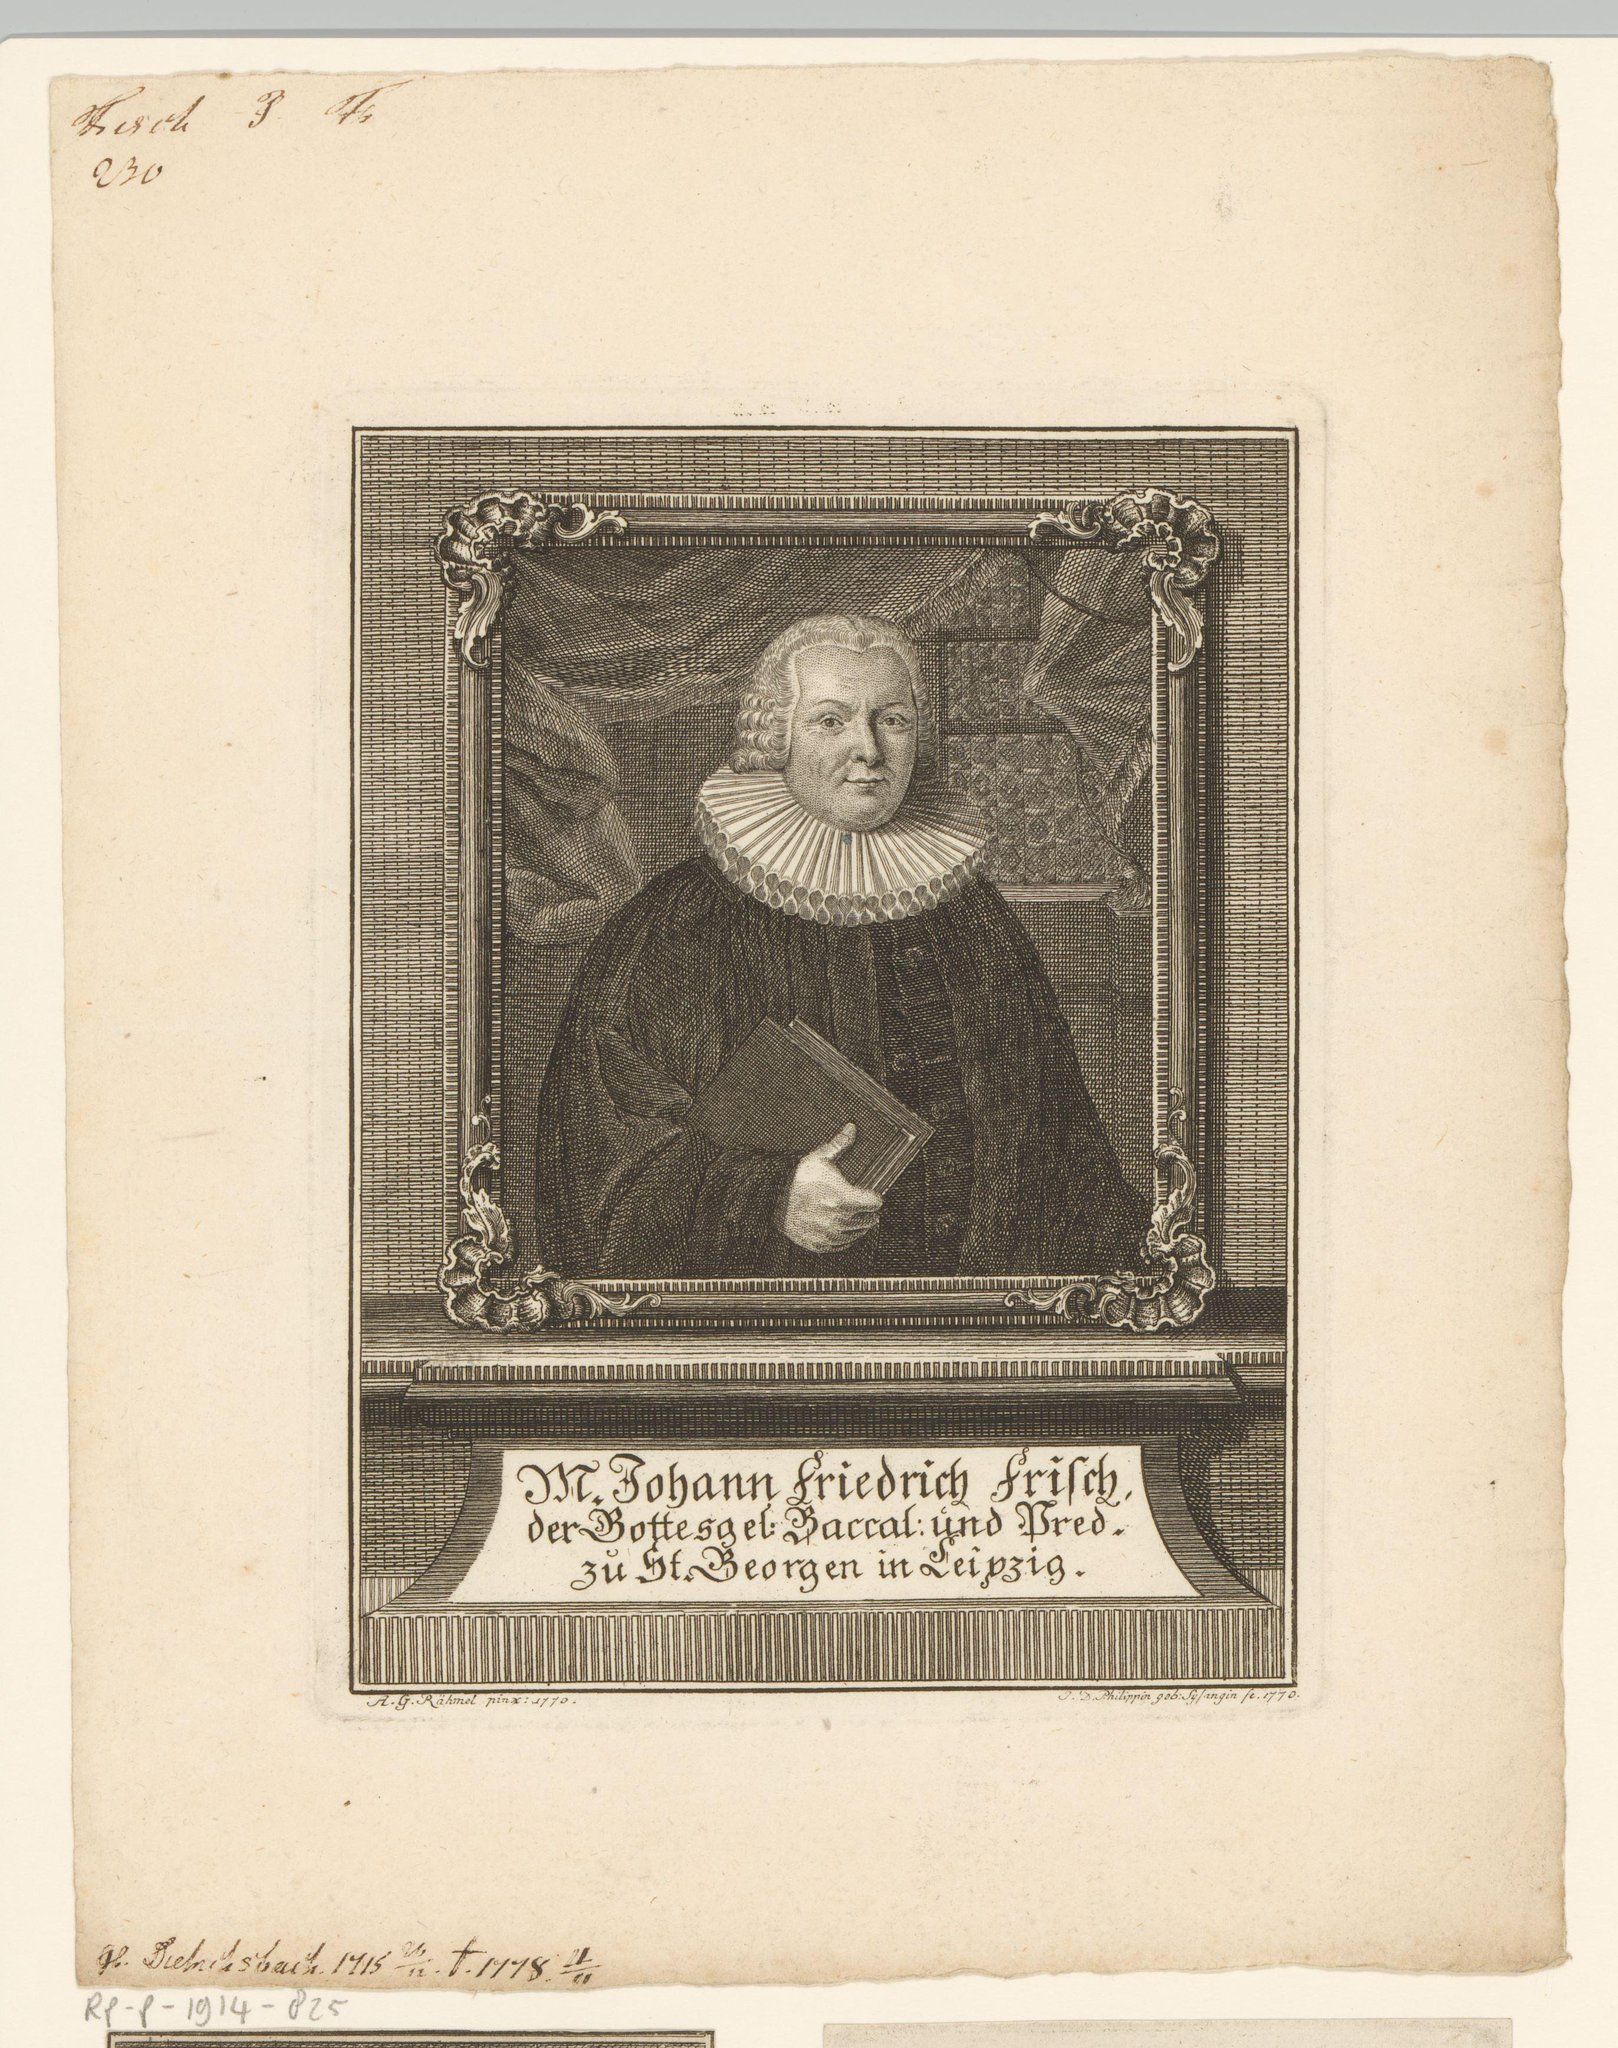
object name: print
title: Portret van Johann Friedrich Frisch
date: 1770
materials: paper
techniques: engraving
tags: bookshelves, historical persons, book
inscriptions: collector's mark: Lugt 2228